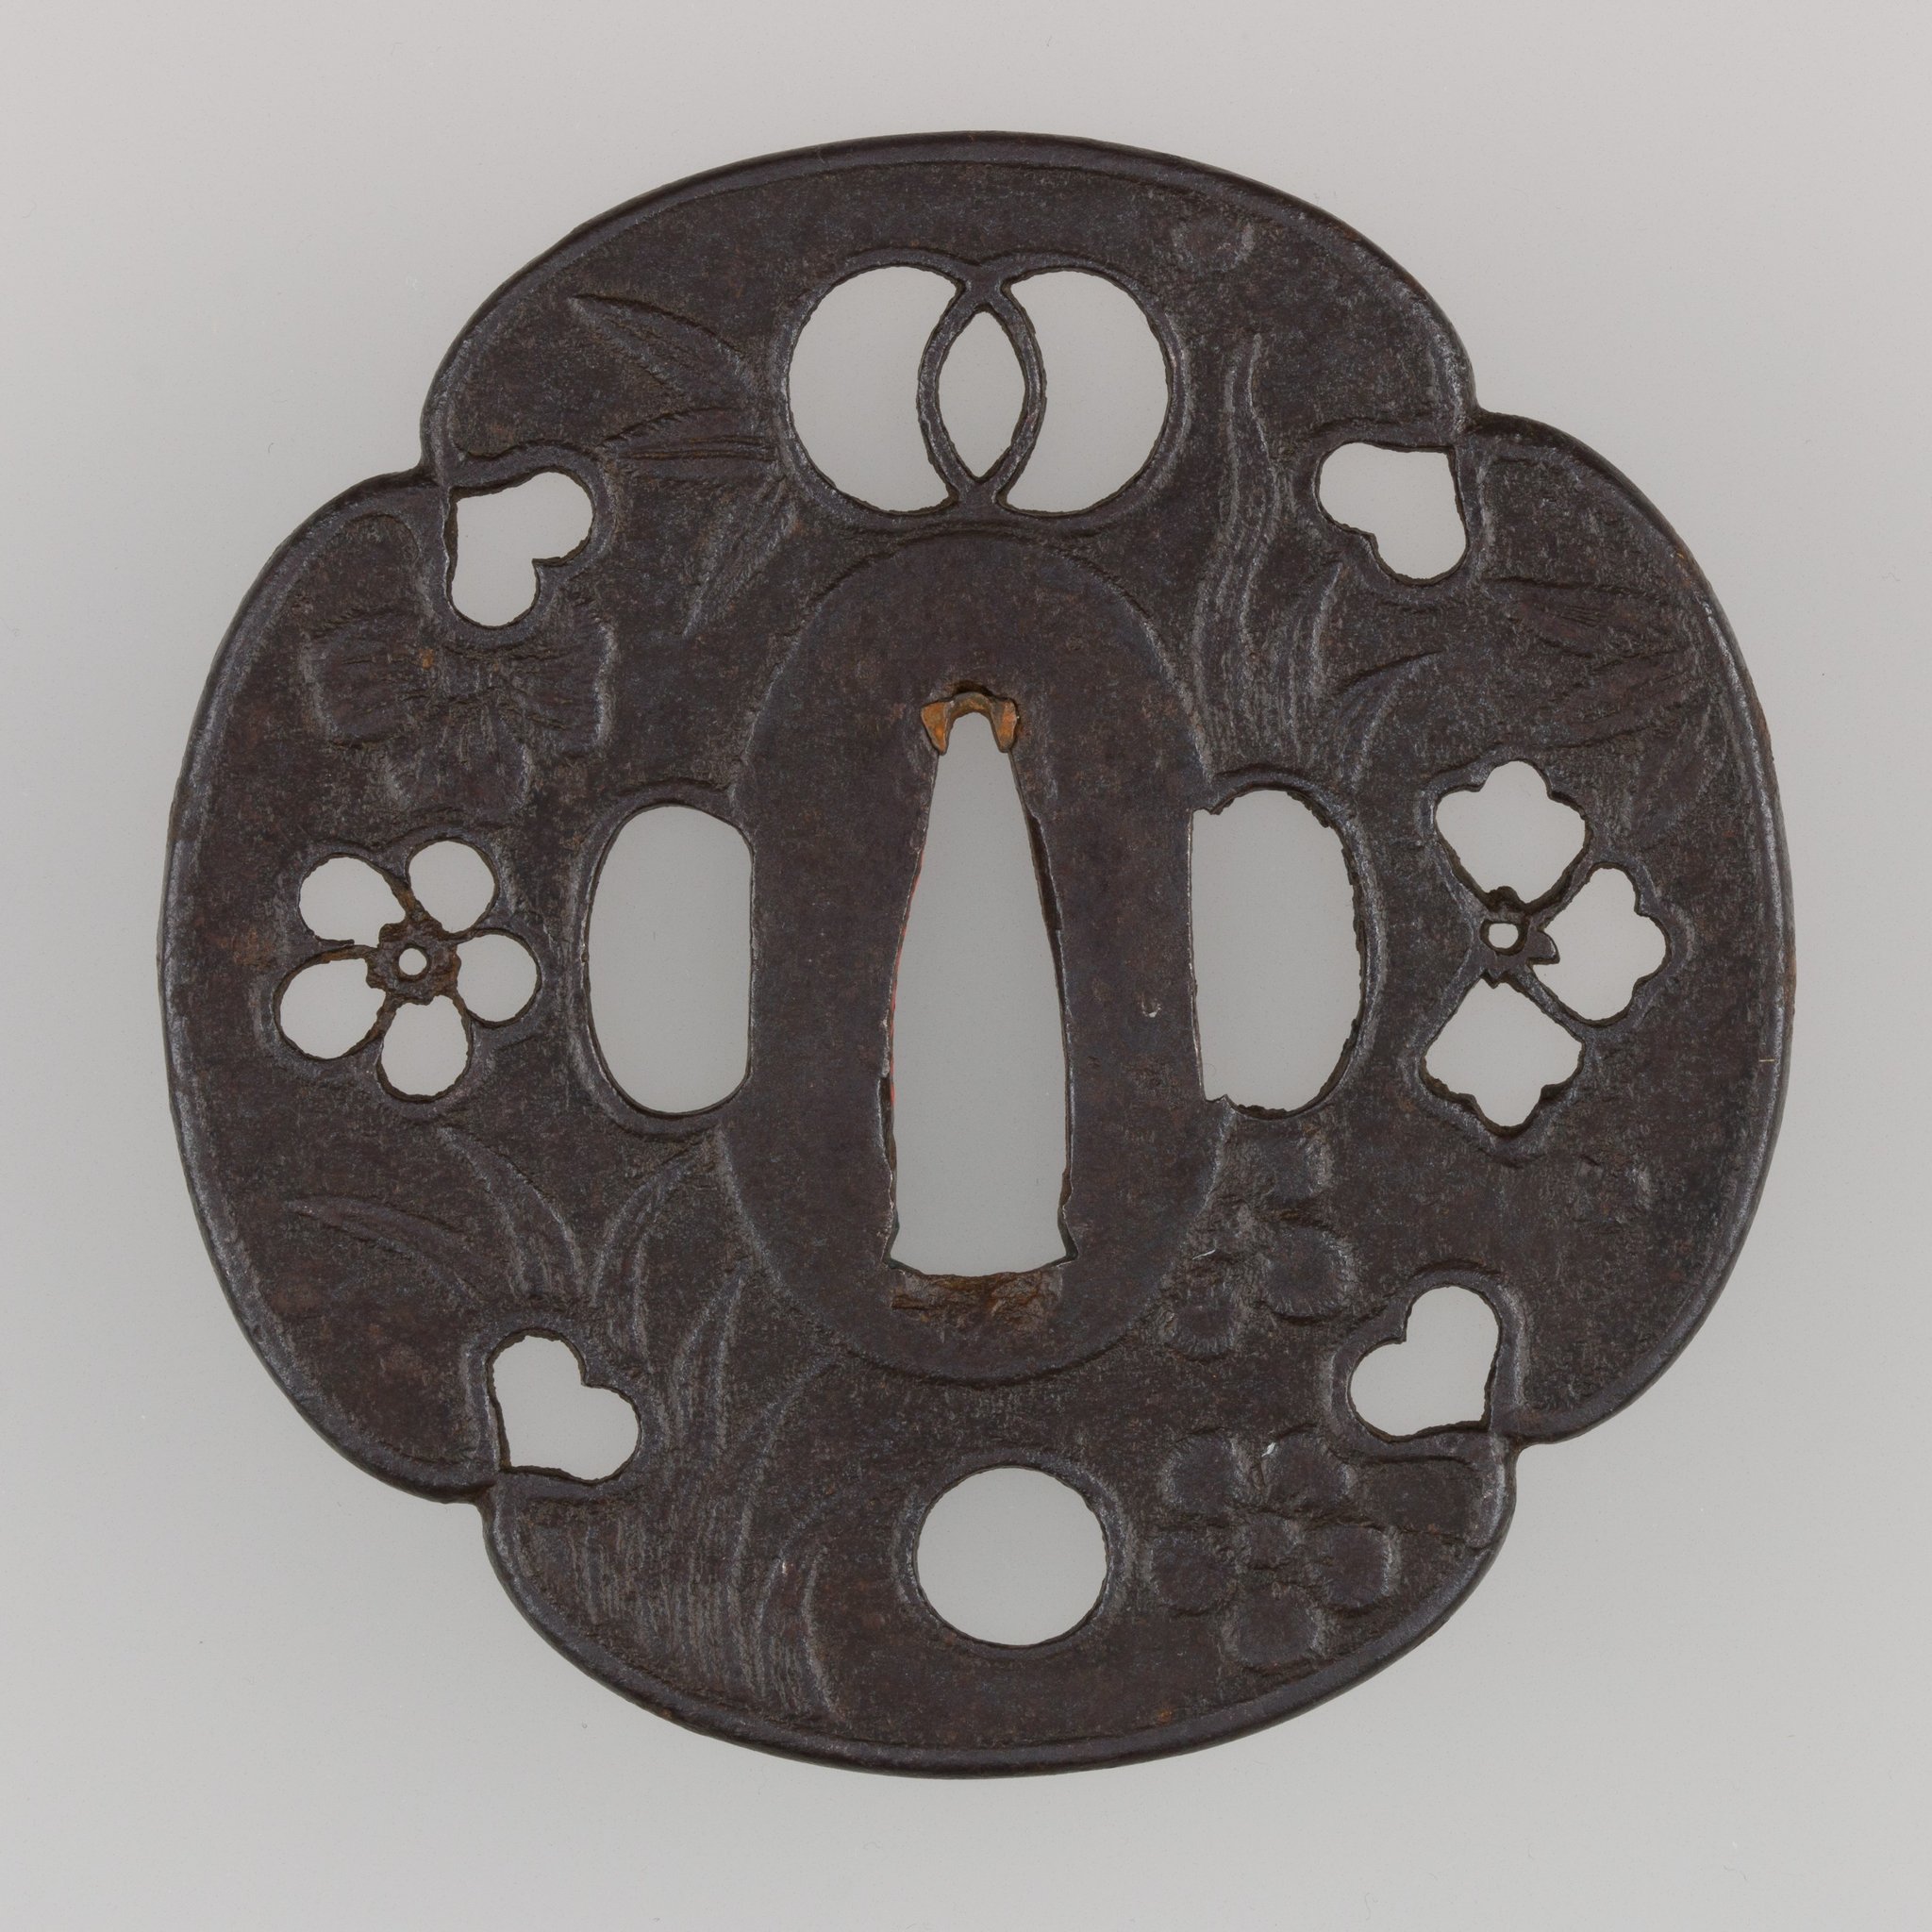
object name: sword guard tsuba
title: Sword Guard (Tsuba)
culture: japanese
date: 1601-1633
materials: copper, iron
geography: japan